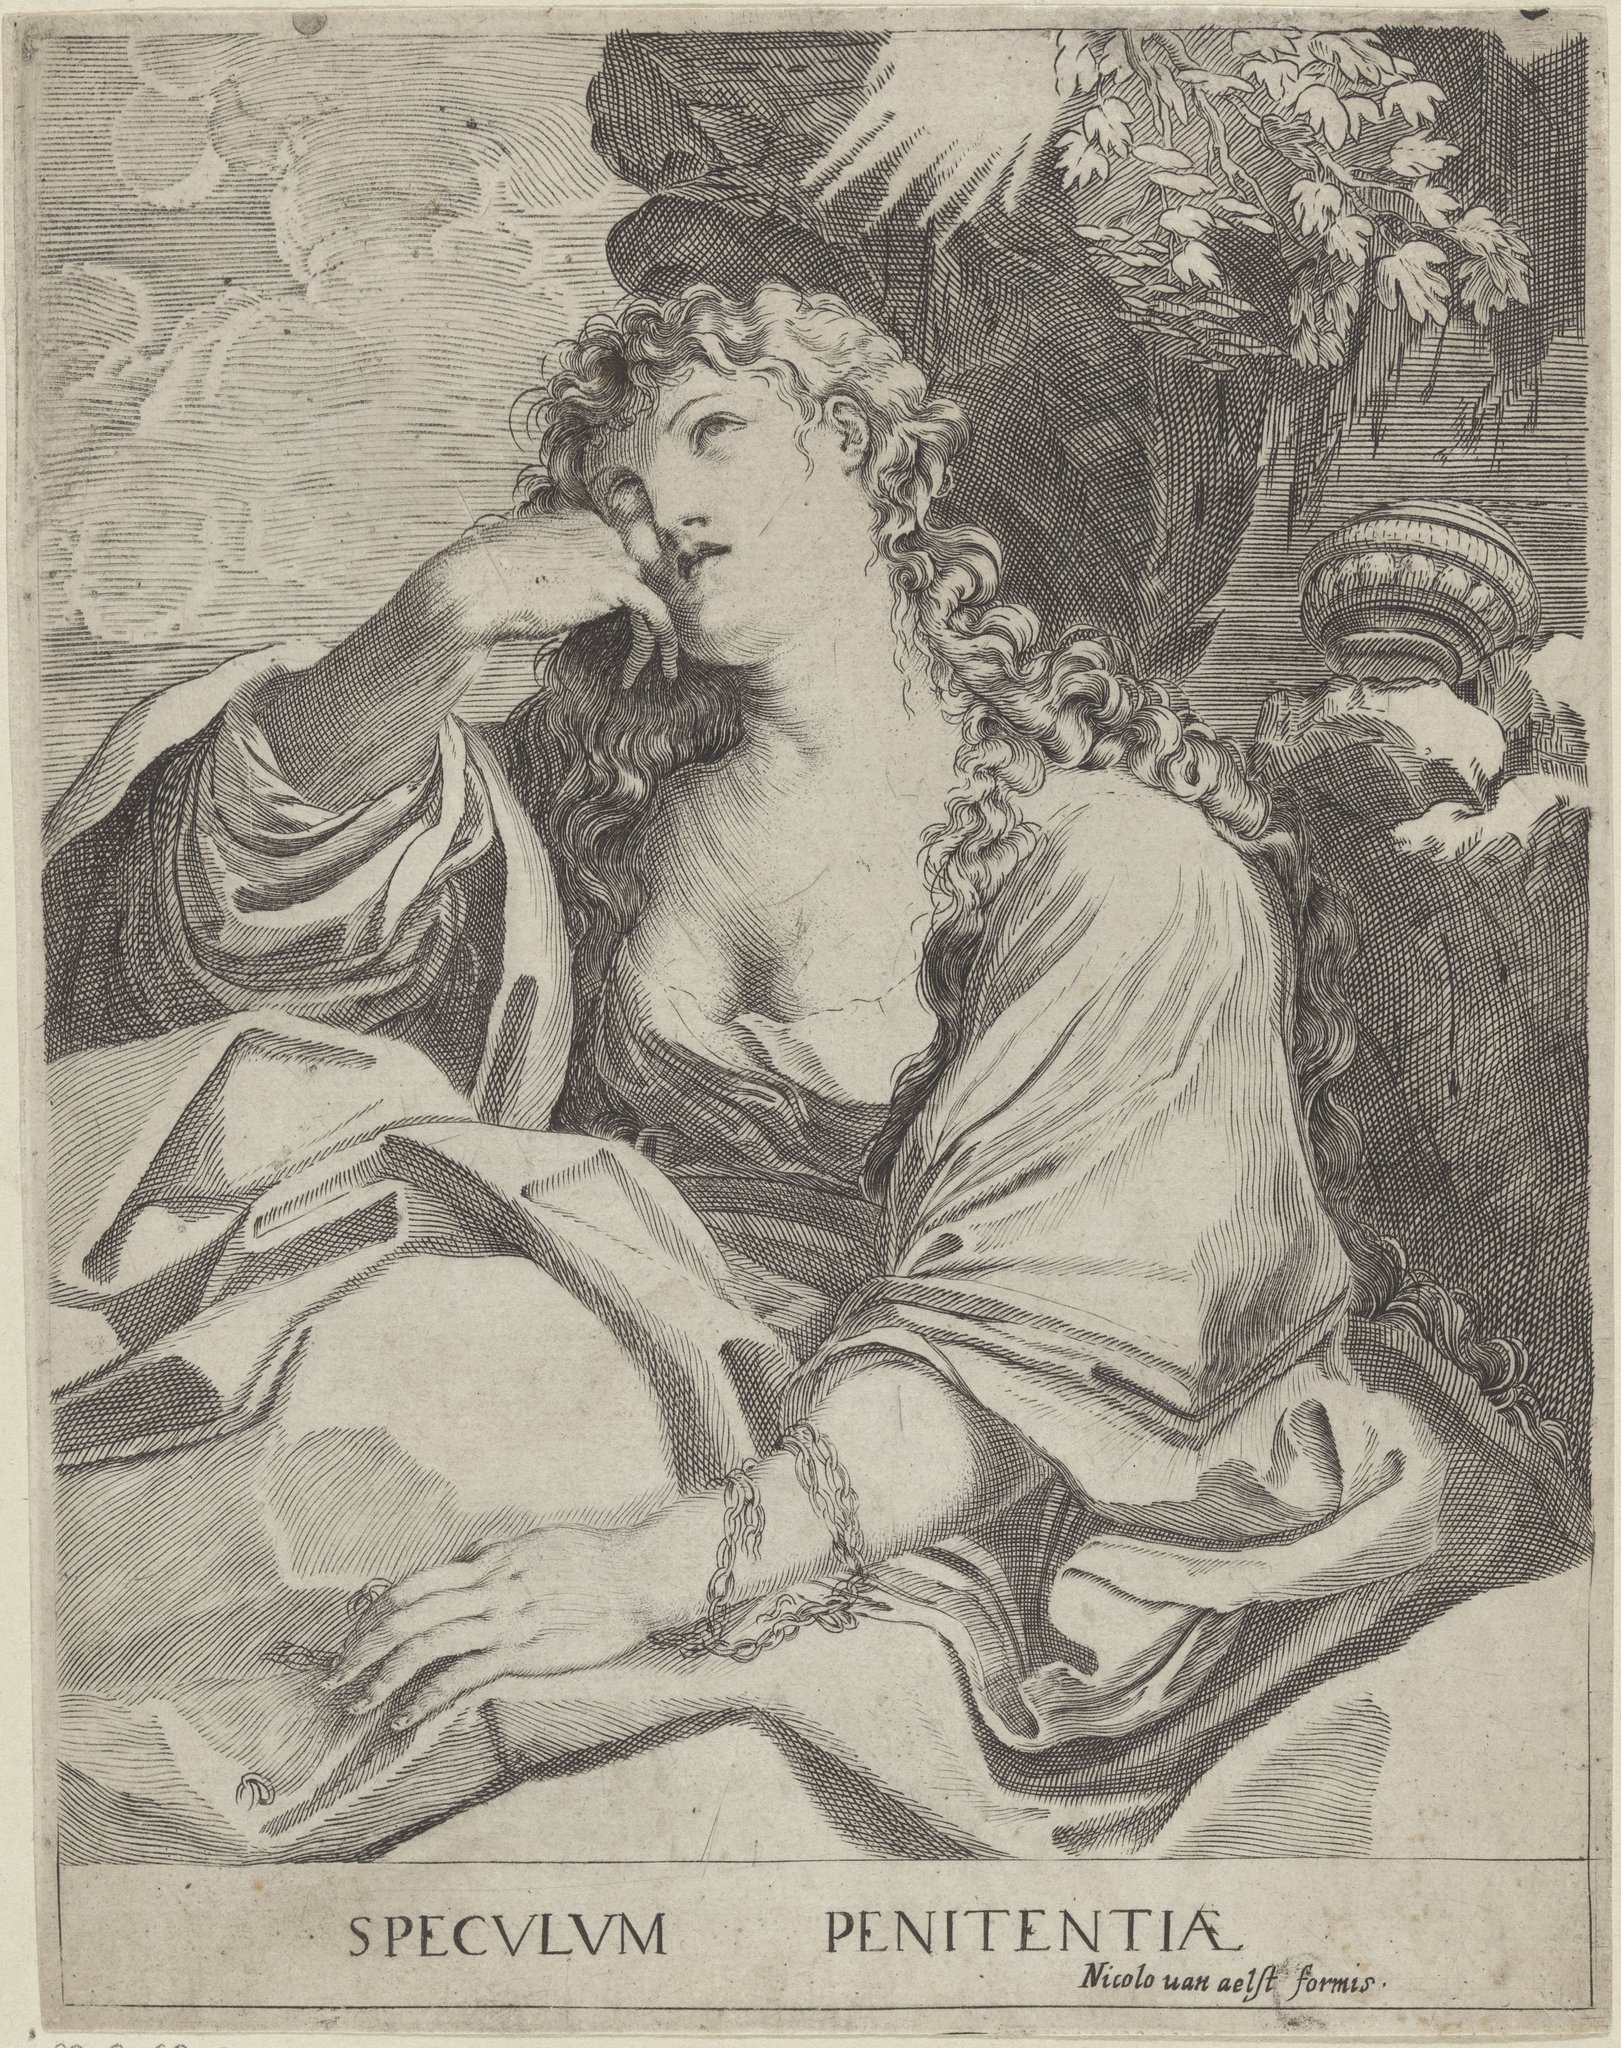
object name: print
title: Maria Magdalena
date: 1584-1623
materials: paper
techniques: engraving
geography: italy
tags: the penitent harlot mary magdalene; possible attributes: book (or scroll), crown, crown of thorns, crucifix, jar of ointment, mirror, musical instrument, palm-branch, rosary, scourge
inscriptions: collector's mark: Lugt 240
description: Maria Magdalena in een landschap. Op de achtergrond rechts staat een zalfpot.